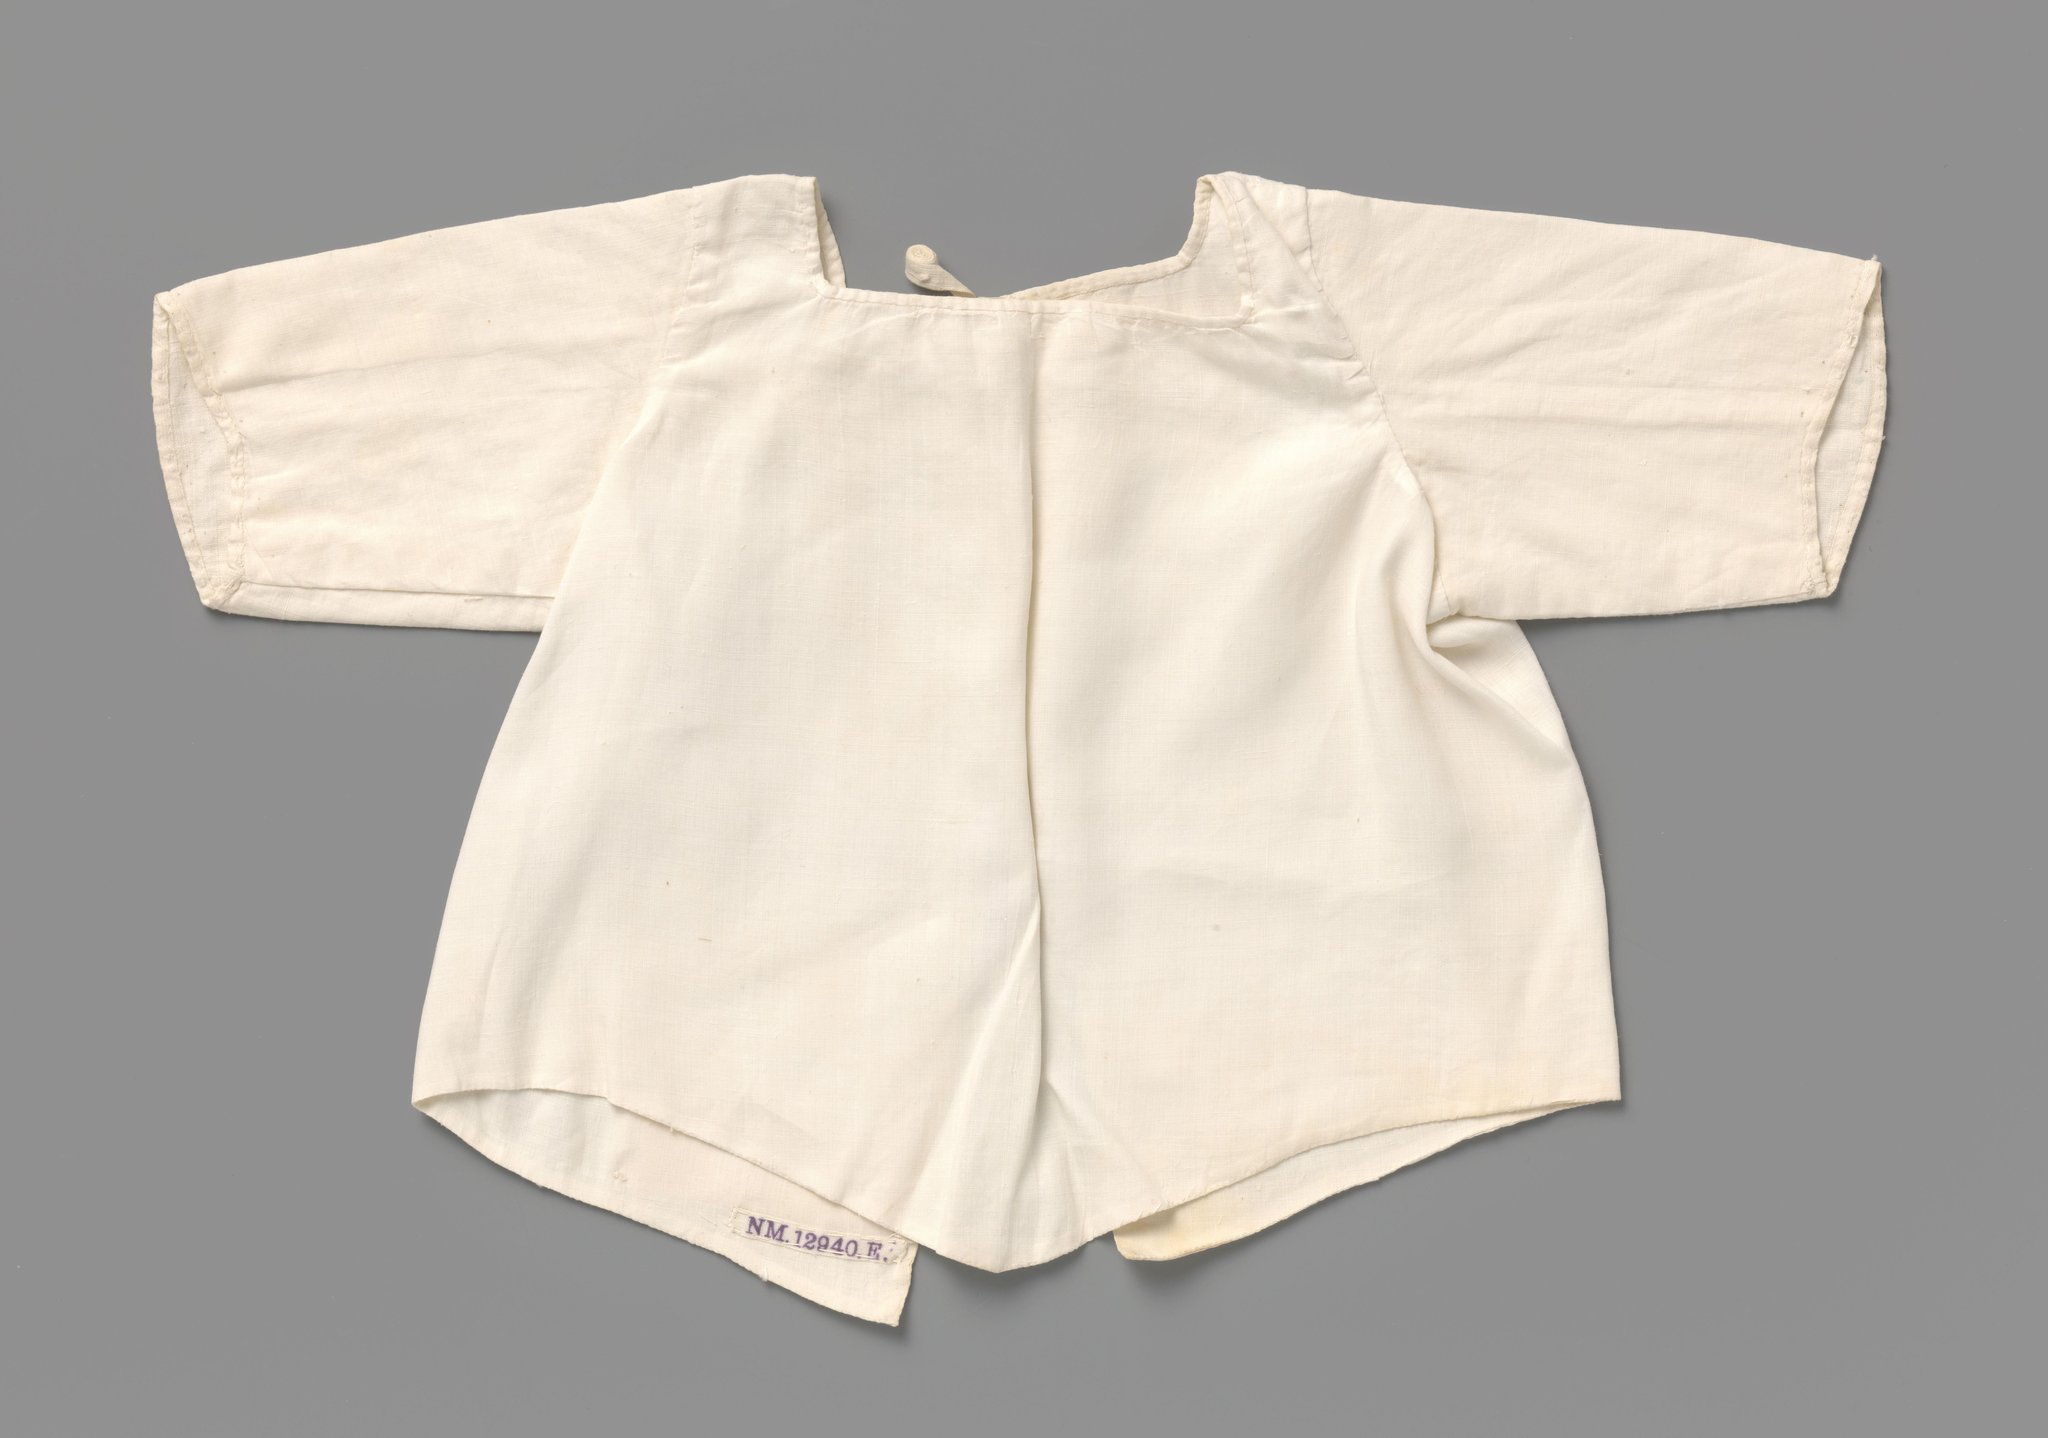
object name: chemise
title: Halfhemd voor een kind van wit linnen, met twee strikbanden bovenaan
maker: Anonymous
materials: linen